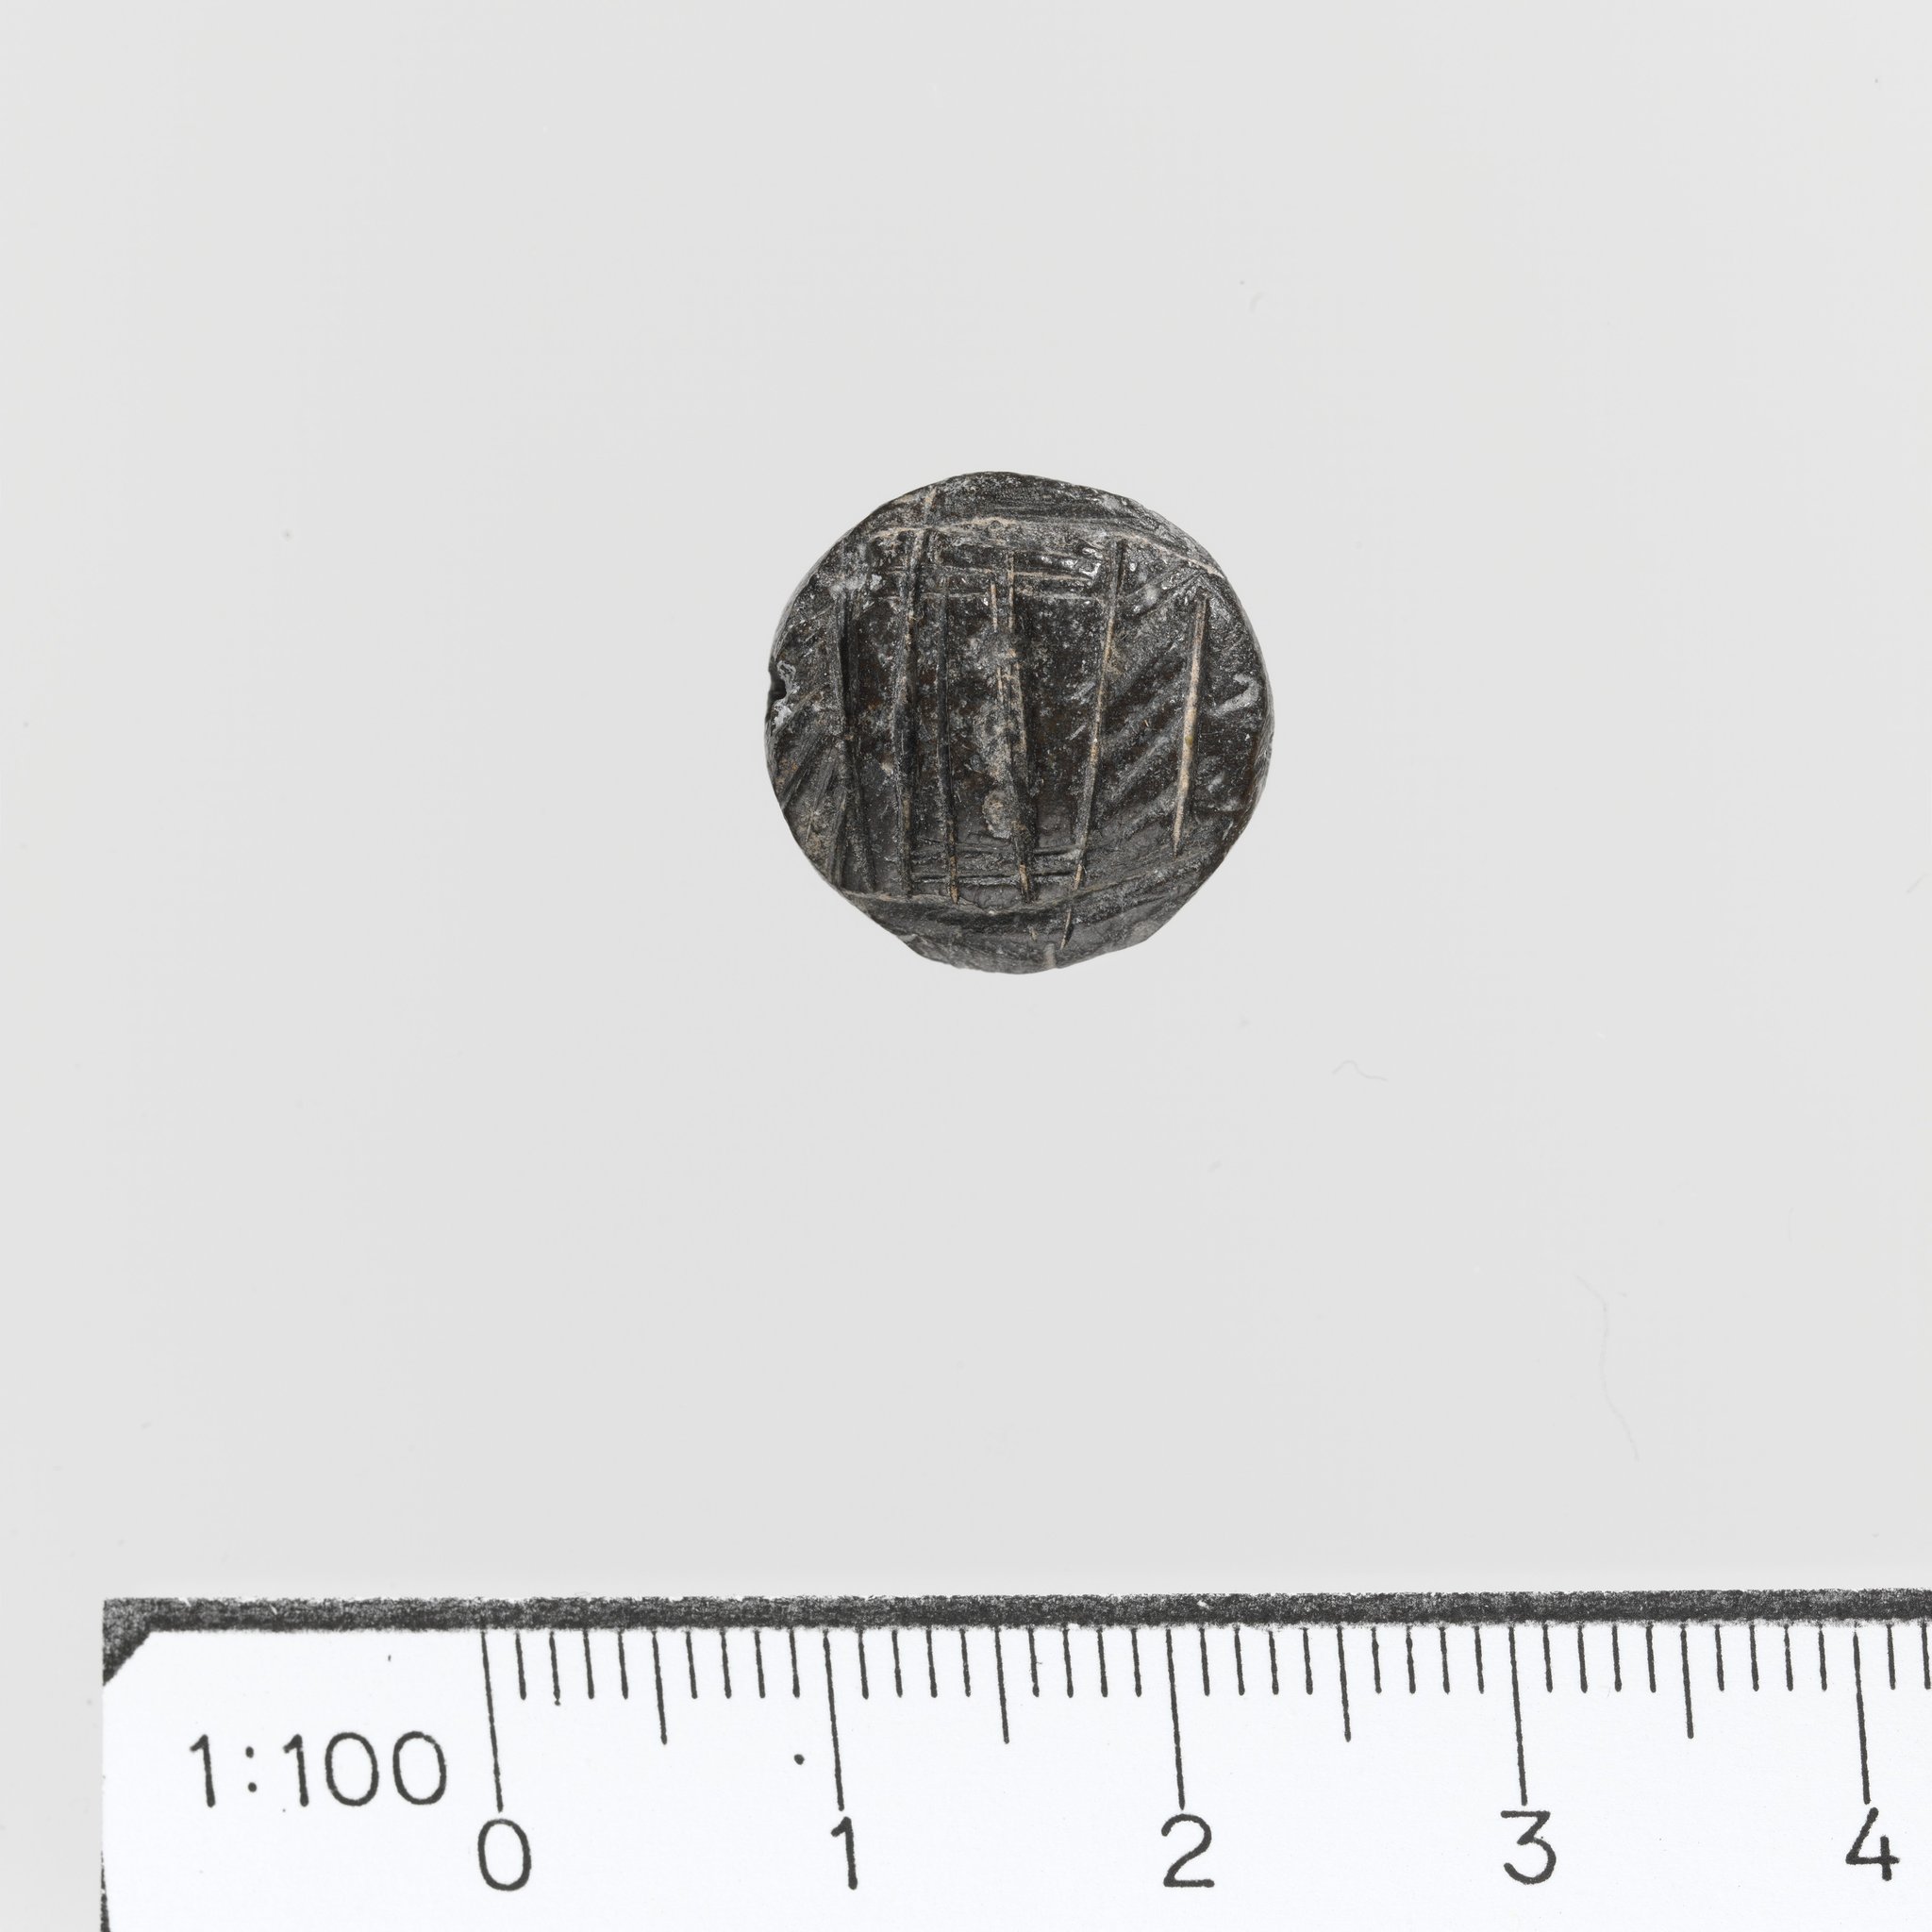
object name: seal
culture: minoan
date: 2600-2000 BCE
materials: stone